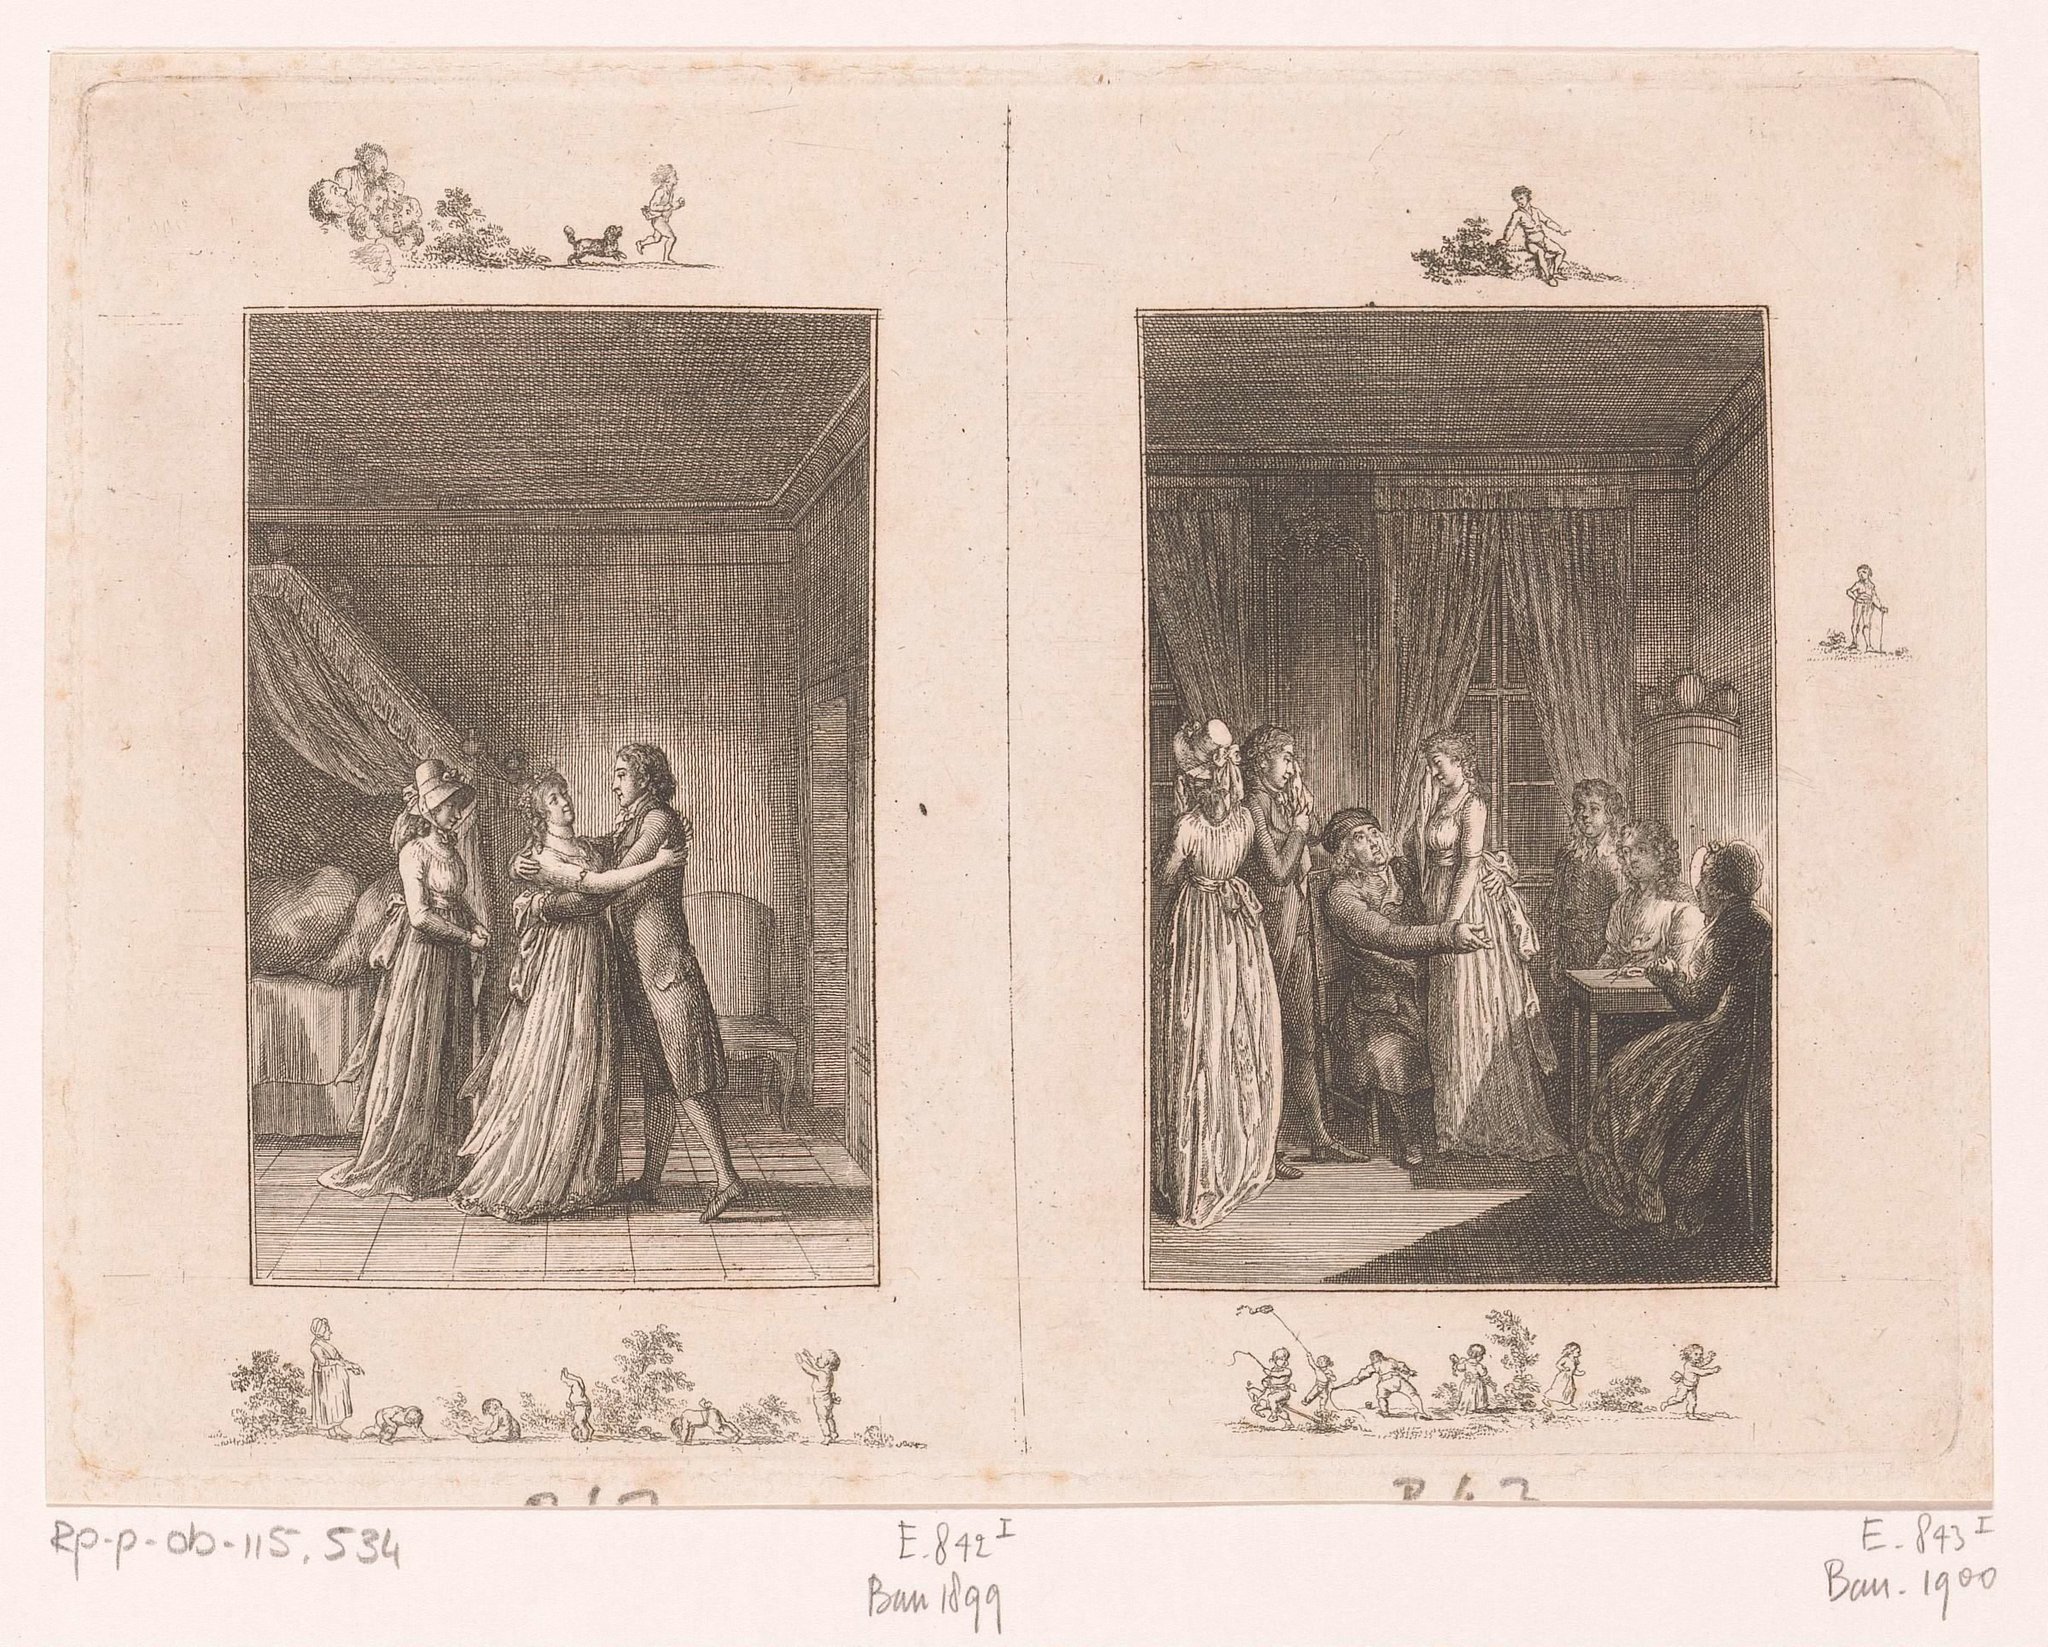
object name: print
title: Twee voorstellingen uit de verhalen van Wilhelm Gottlieb Becker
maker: daniel nikolaus chodowiecki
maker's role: draughtsman, print maker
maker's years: 1726-1801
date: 1797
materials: paper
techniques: etching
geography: berlin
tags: consolation, literature, (lovers) embracing each other, 'symplegma', weeping, bedroom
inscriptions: collector's mark: Lugt 2228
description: Latere staat gebruikt voor: Becker, Wilhelm Gottlieb. Almanach und Taschenbuch zum geselligen Vergnügen von W. G. Becker für 1798. Leipzig: Voss und Comp., [1797].